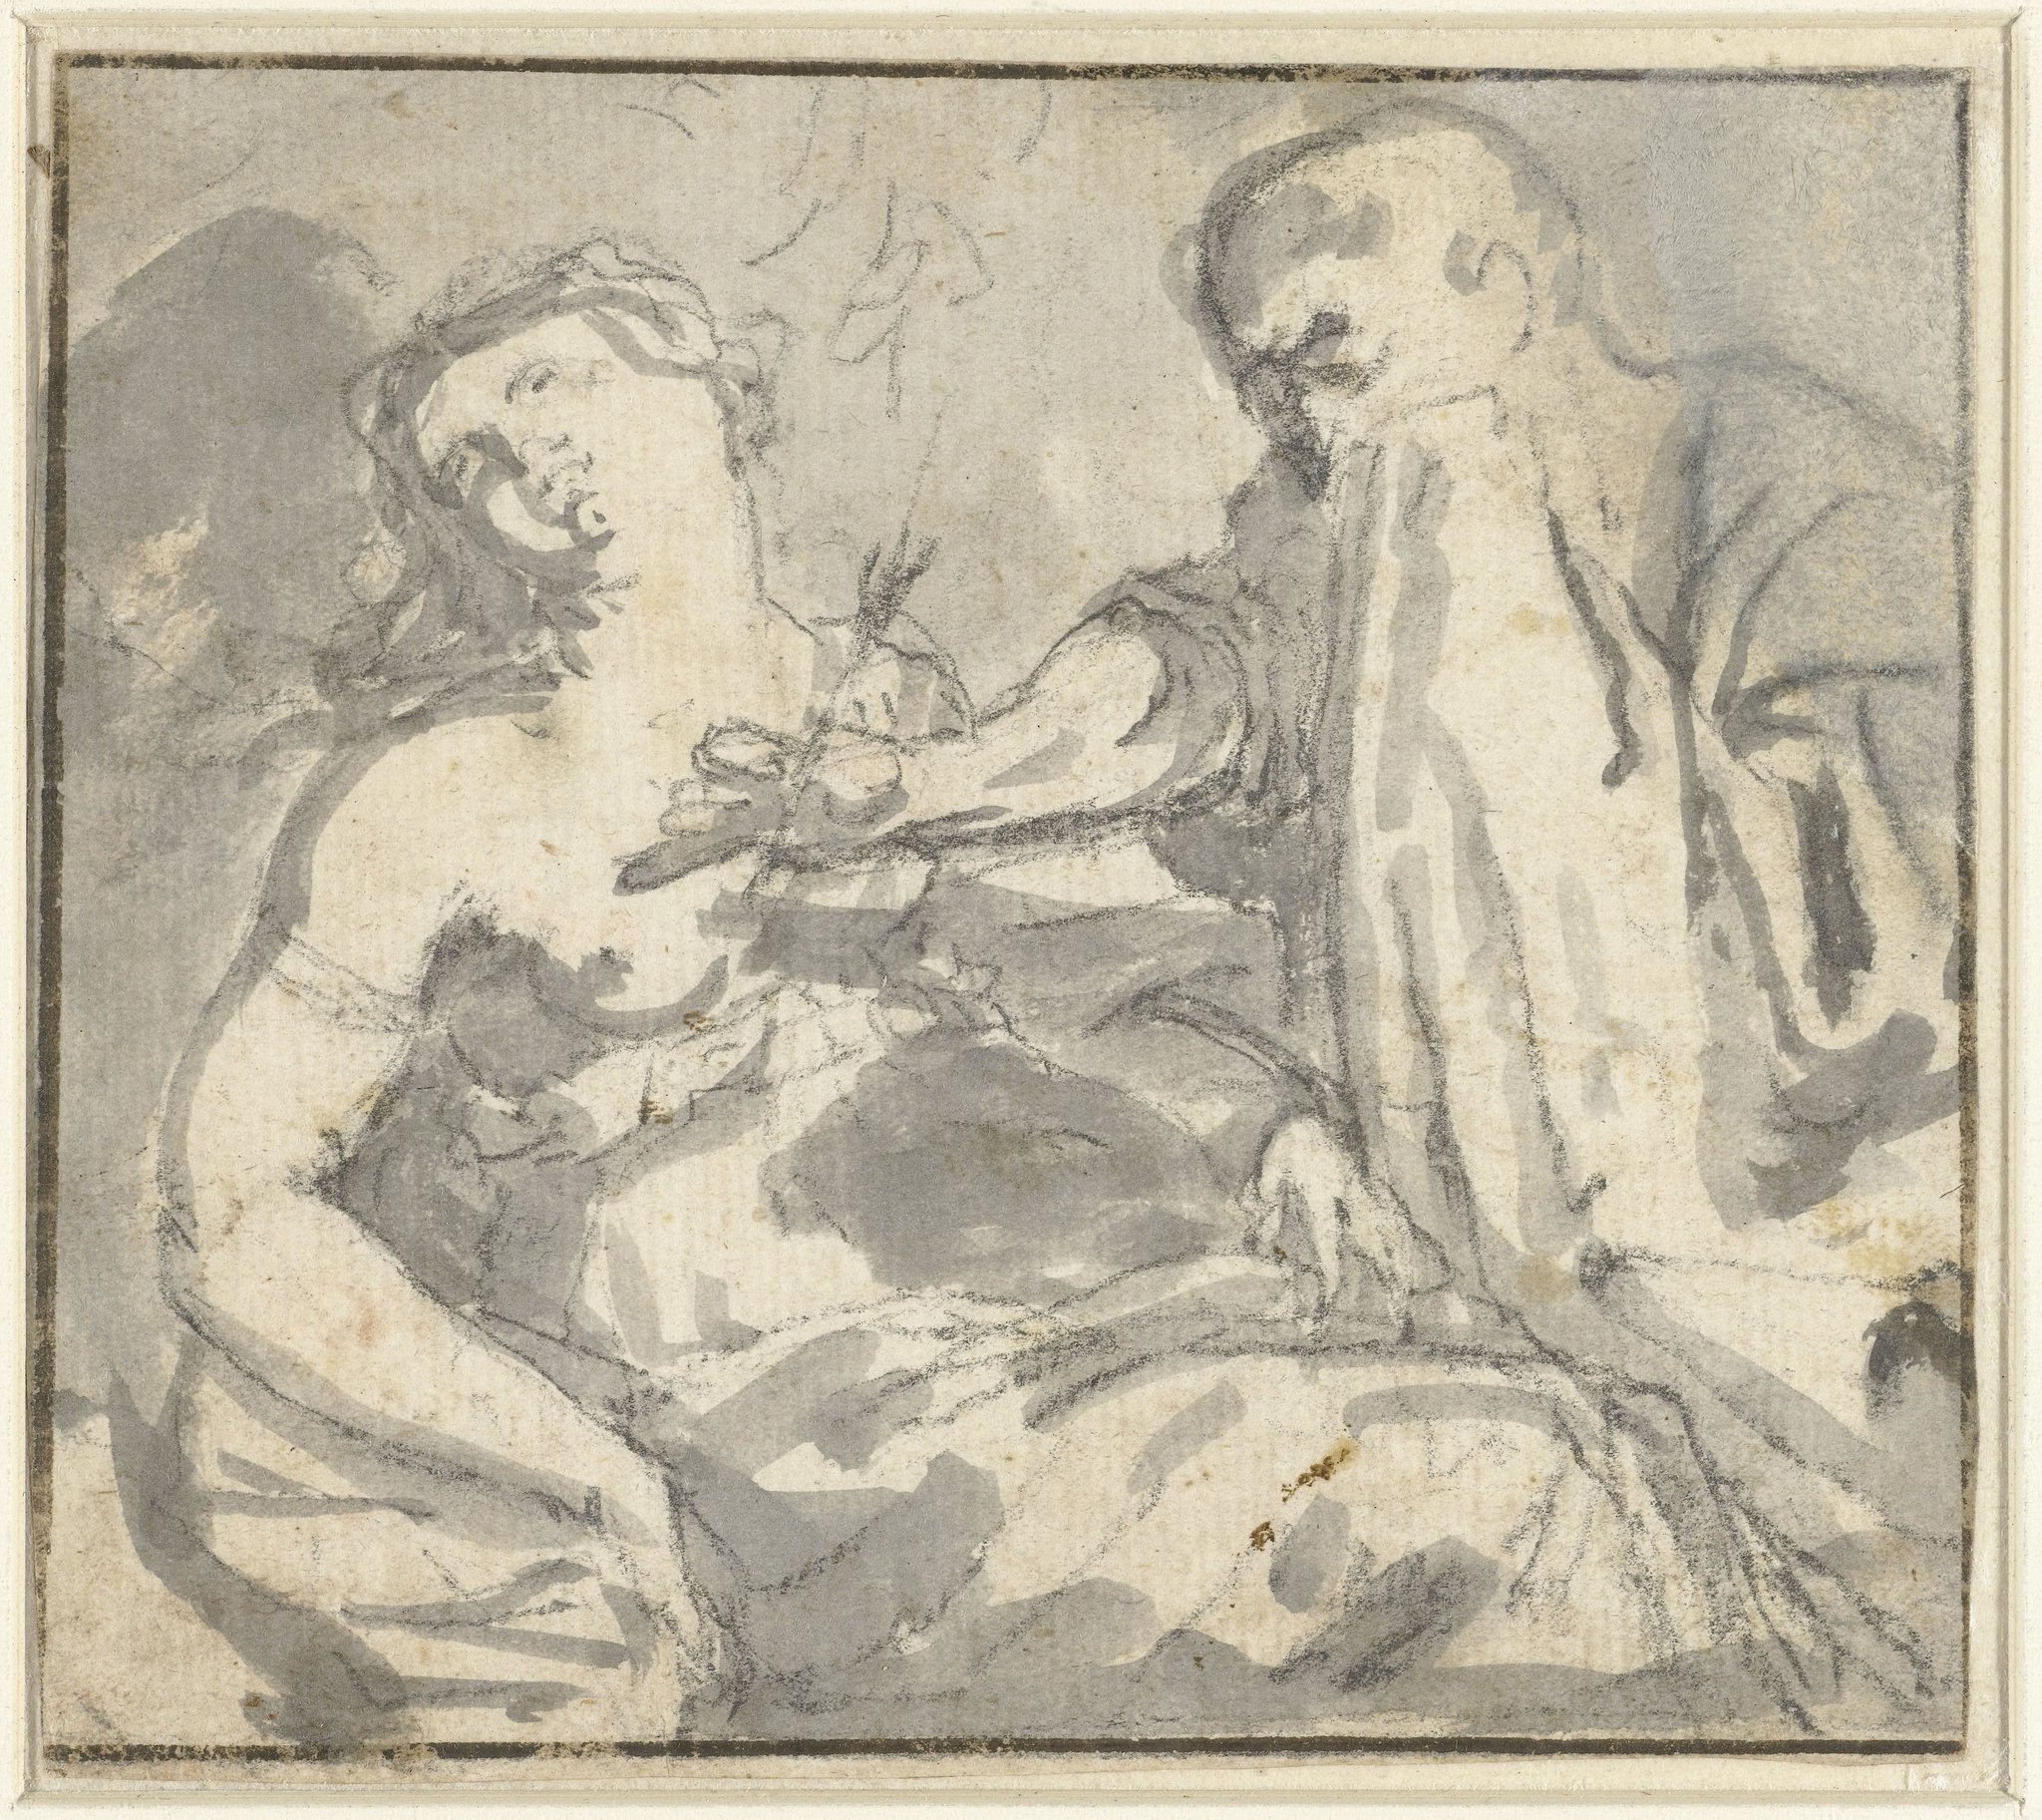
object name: drawing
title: Een man verwijdert een pijl uit de borst van een vrouw (Cephalus en Procris?)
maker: Anonymous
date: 1600-1699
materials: chalk, paper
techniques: brush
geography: naples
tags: mourning of procris